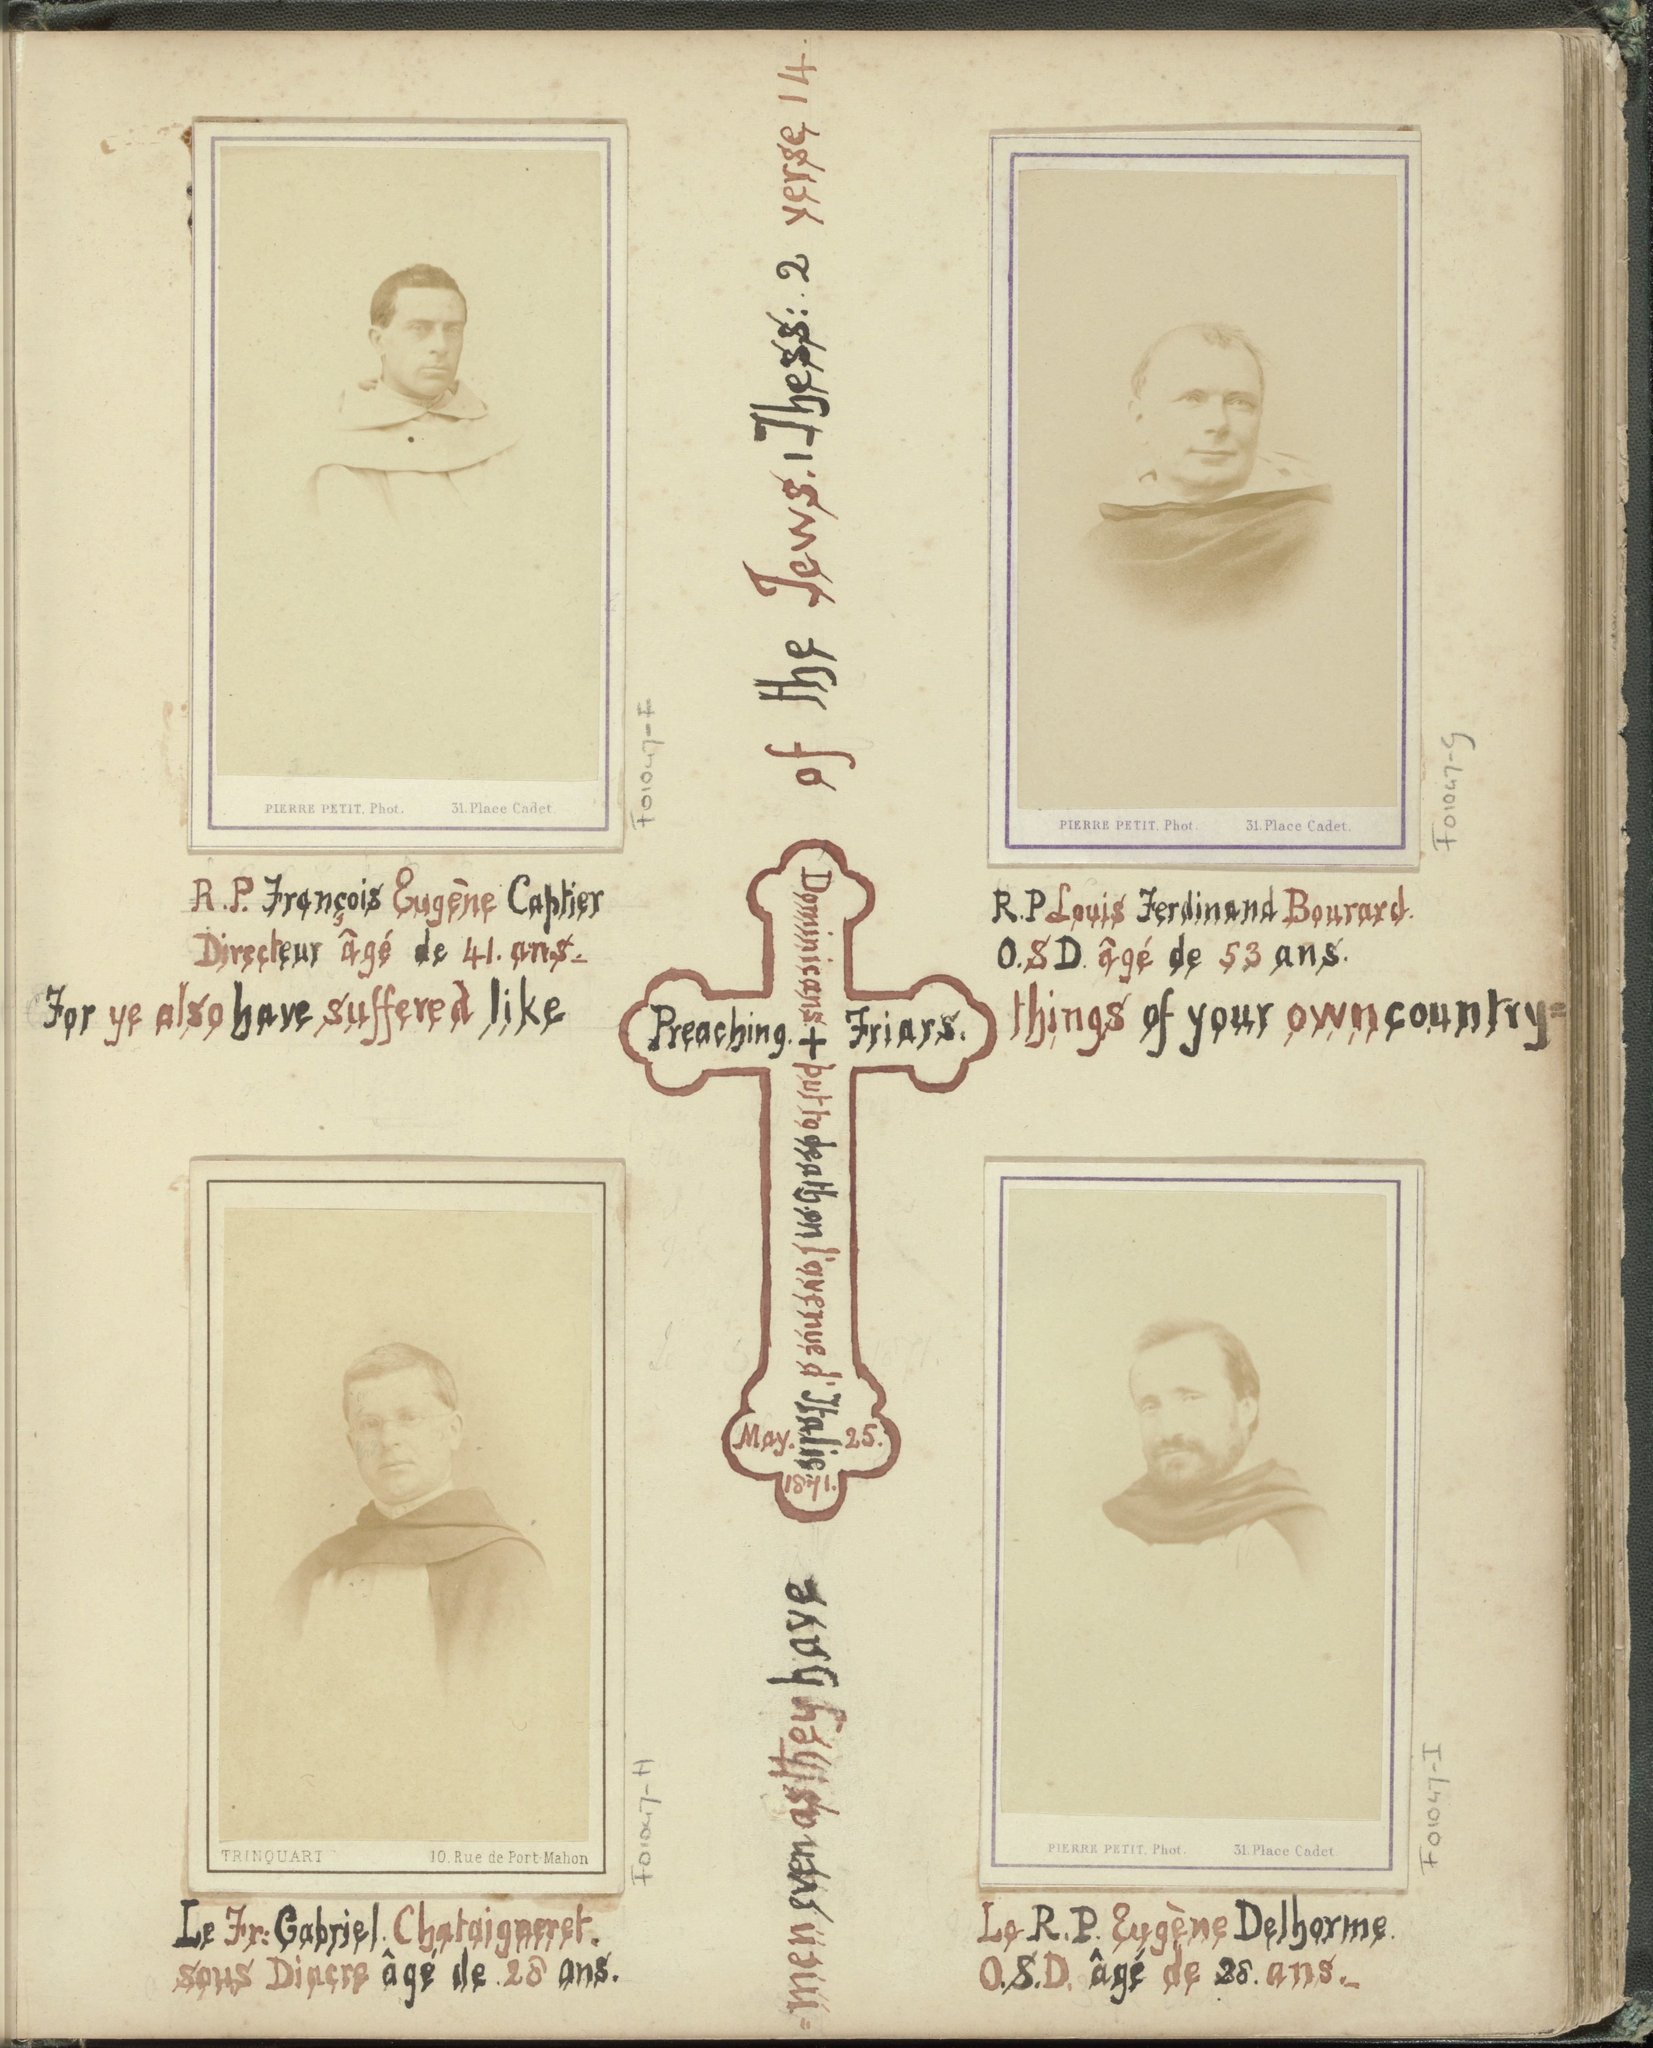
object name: photograph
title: Portret van Frère Gabriel Chataigneret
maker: antoine rené trinquart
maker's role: fotograaf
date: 1871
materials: cardboard, paper, photographic support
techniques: albumen print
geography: paris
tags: monk(s), friar(s)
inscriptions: address: ‘10, Rue de Port-Mahon’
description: Onderdeel van Herdenkingsalbum van rooms-katholieke geestelijken gevallen tijdens de Commune van Parijs.